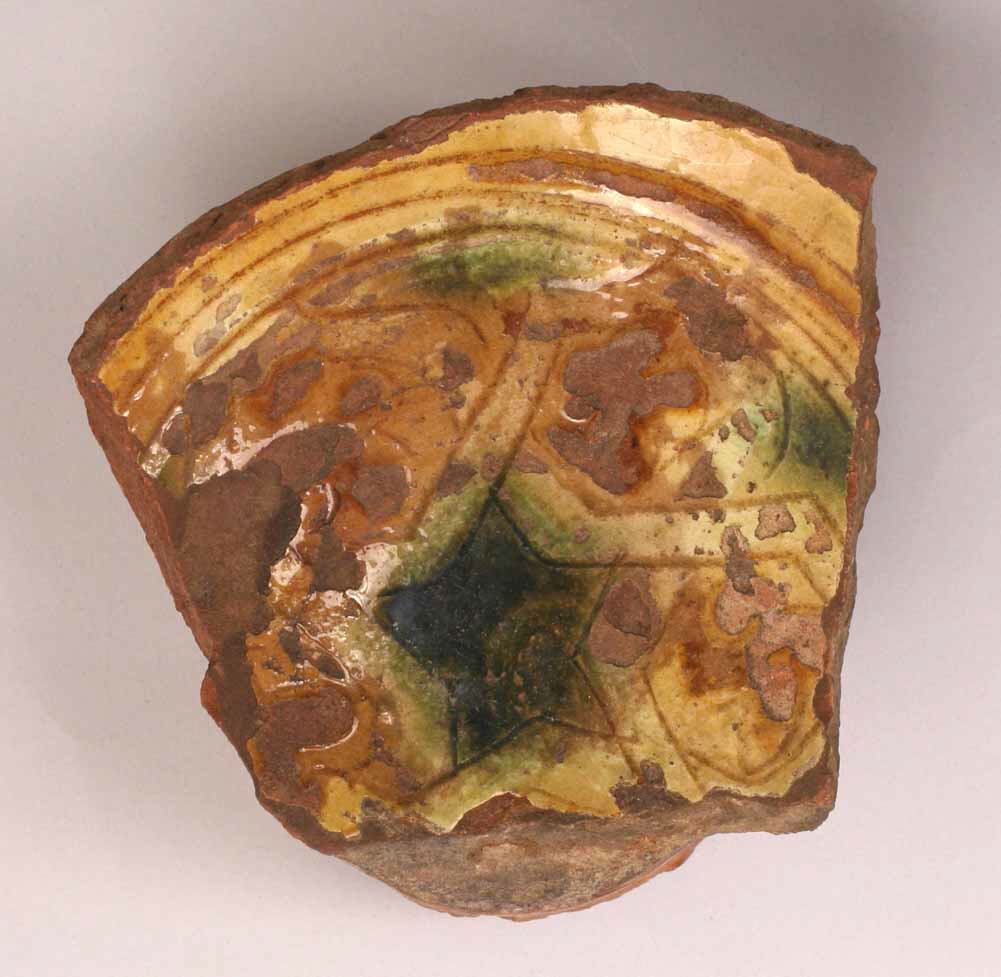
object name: fragment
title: Ceramic Fragment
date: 1401-1500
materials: earthenware, glaze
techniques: coloring, incising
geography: egypt